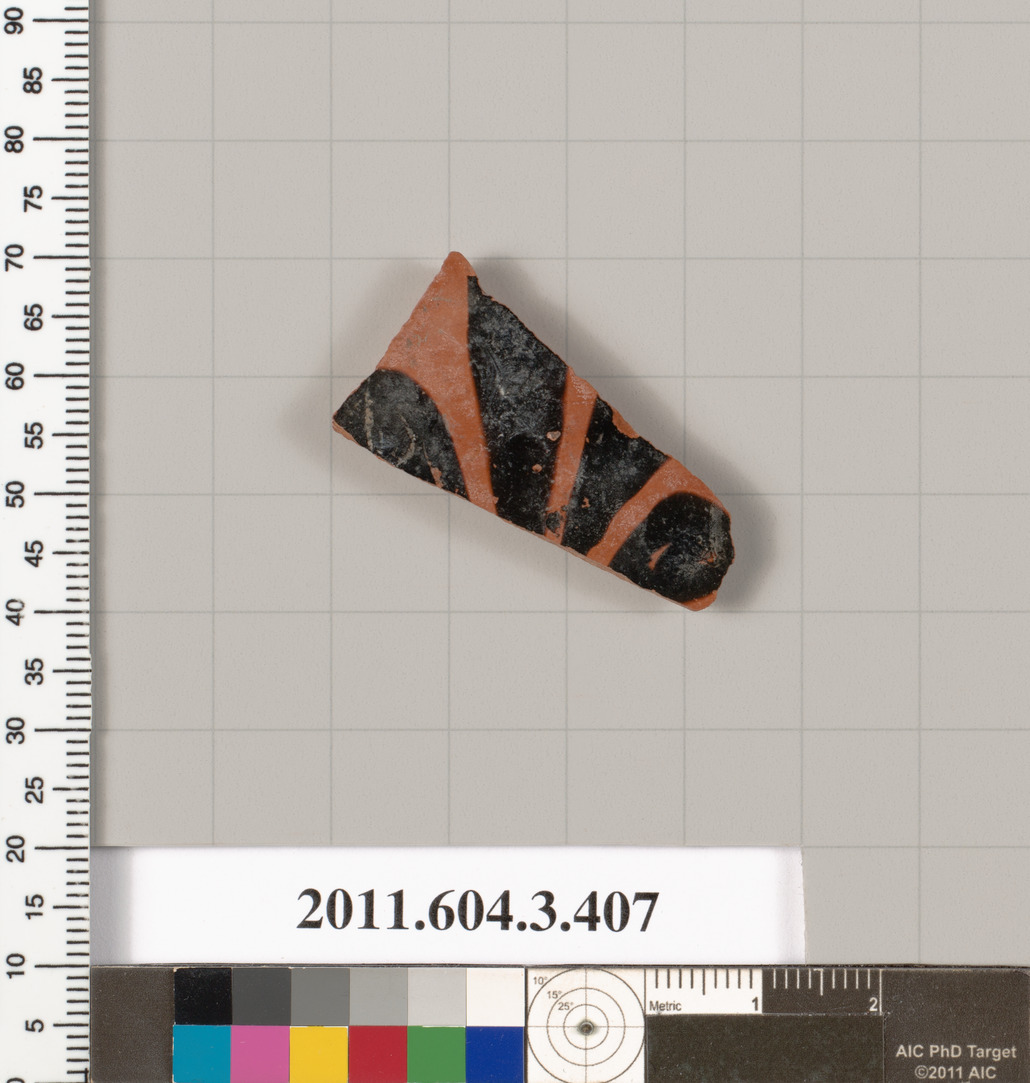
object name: neck amphora fragment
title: Terracotta fragment of a neck-amphora (jar)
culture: greek, attic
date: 500-468 BCE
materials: terracotta